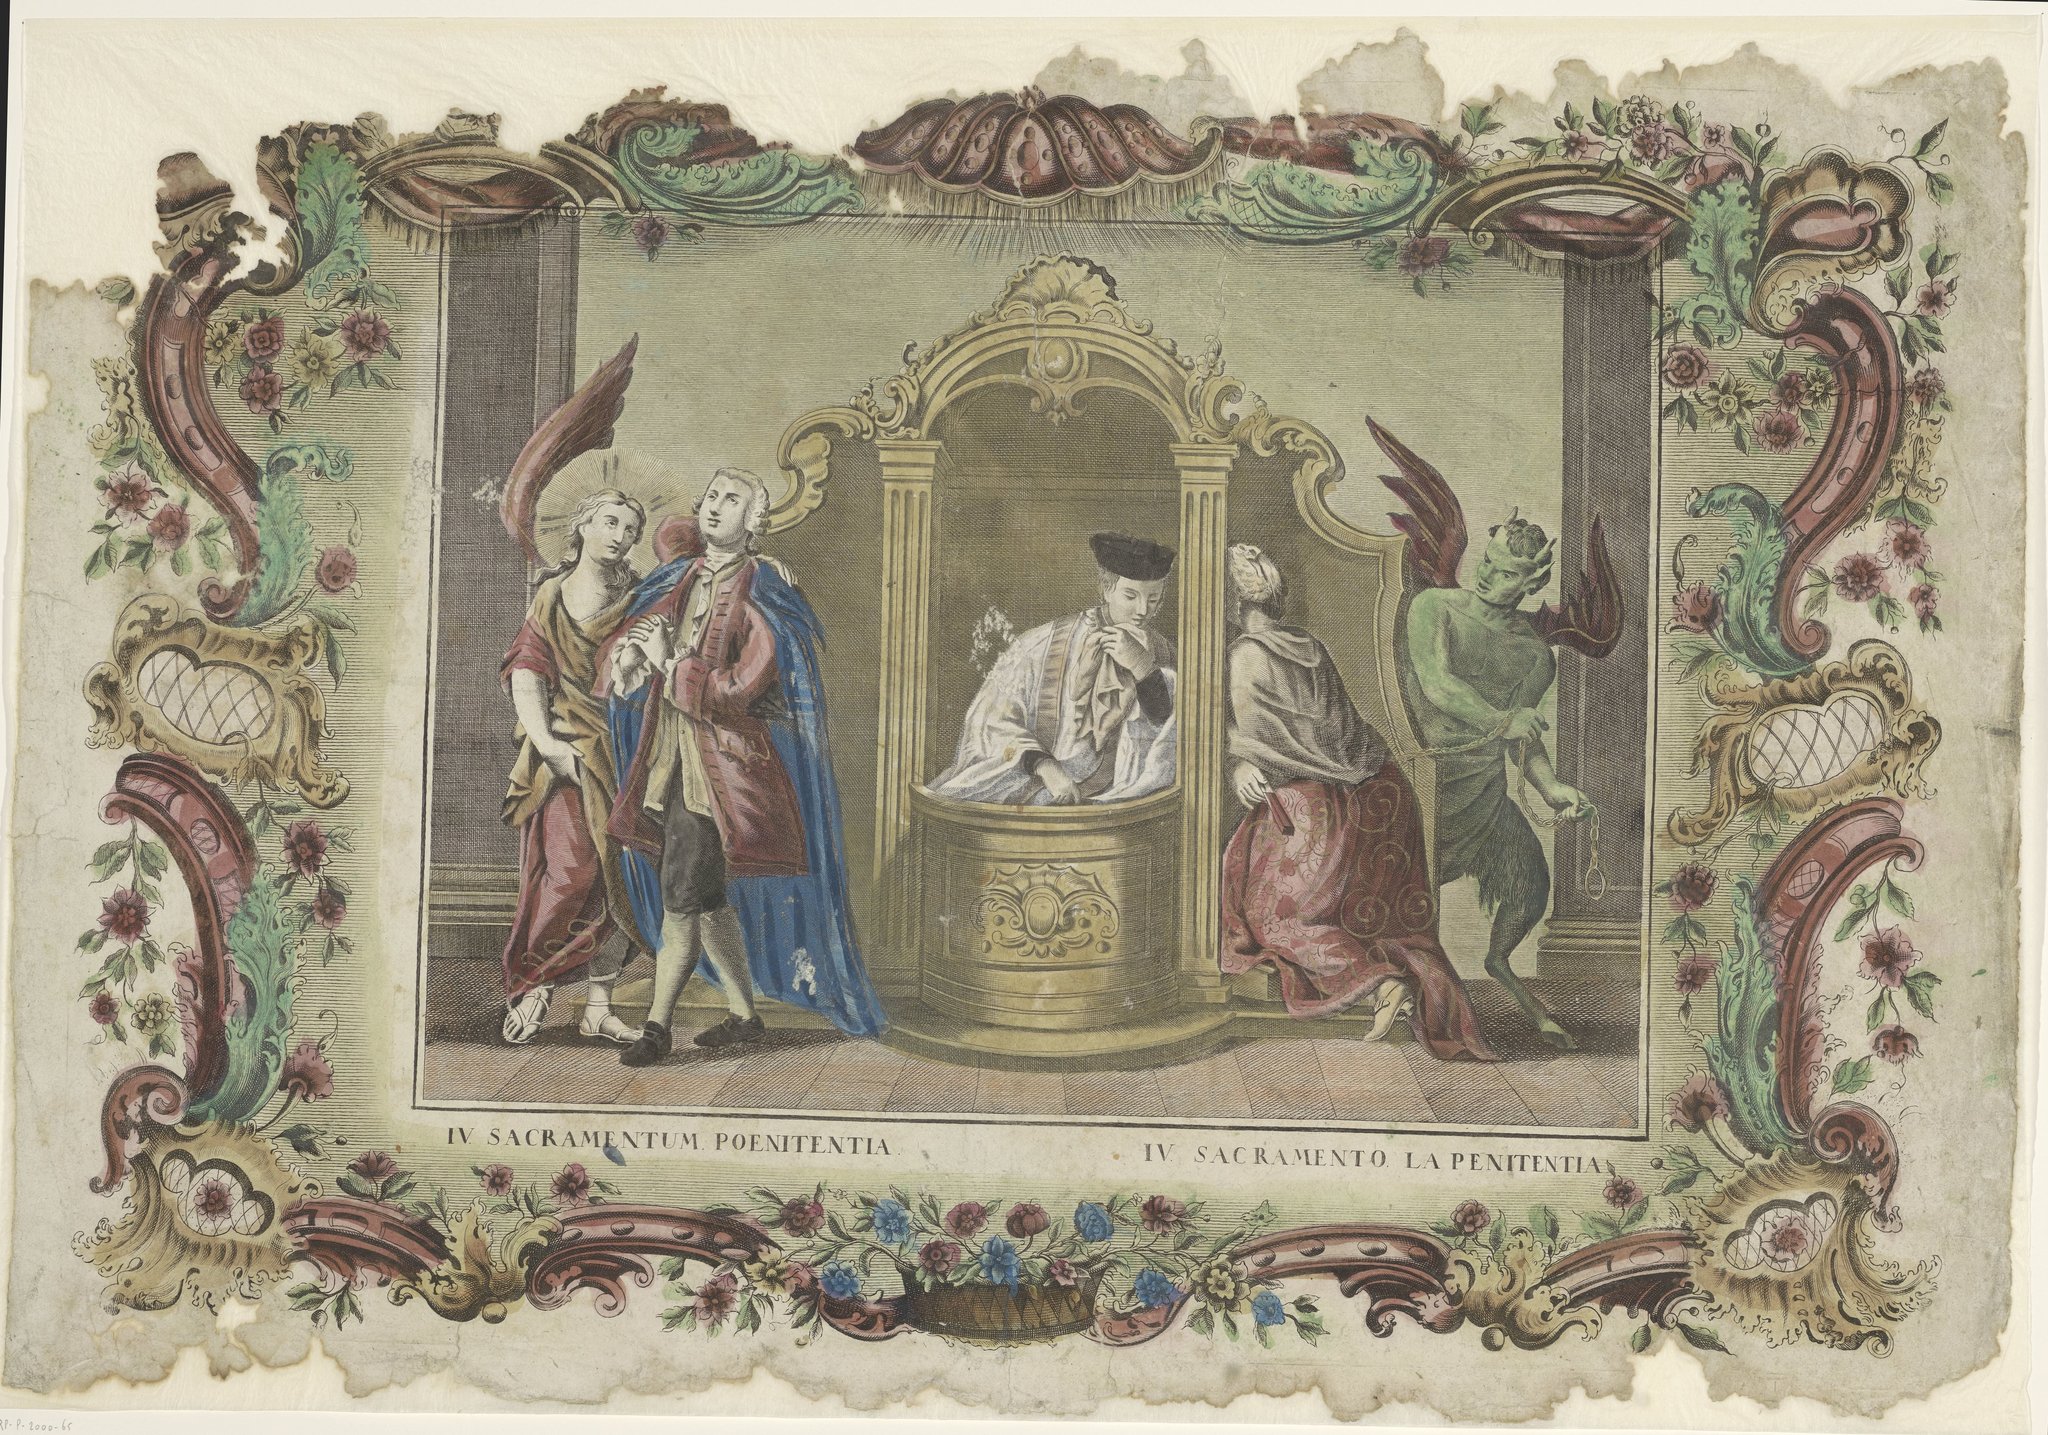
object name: print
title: De zeven sacramenten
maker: giovanni volpato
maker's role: ceramicist, print maker, printer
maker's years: 1735-1803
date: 1700-1799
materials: paper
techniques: colour, engraving, etching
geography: bassano del grappa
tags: ornaments ~ art, devil(s) and demons, confession; 'confessione sacramentale' (ripa) ~ the third of the seven sacraments, angels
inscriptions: collector's mark: Lugt 2760, collector's mark: Lugt 2228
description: Het sacrament van de biecht: een priester zit in een biechtstoel en luistert naar de biecht van een geknielde vrouw, die een keten om haar middel heeft die wordt vastgehouden door een duivel. Links loopt een jongeman, die zijn biecht heeft afgelegd, van de biechtstoel weg, de handen gevouwen, zijn blik ten hemel geheven. Een engel loopt naast hem, de arm om zijn schouder. Titel in twee talen onder voorstelling. De scène is gevat in een ornamentrand.